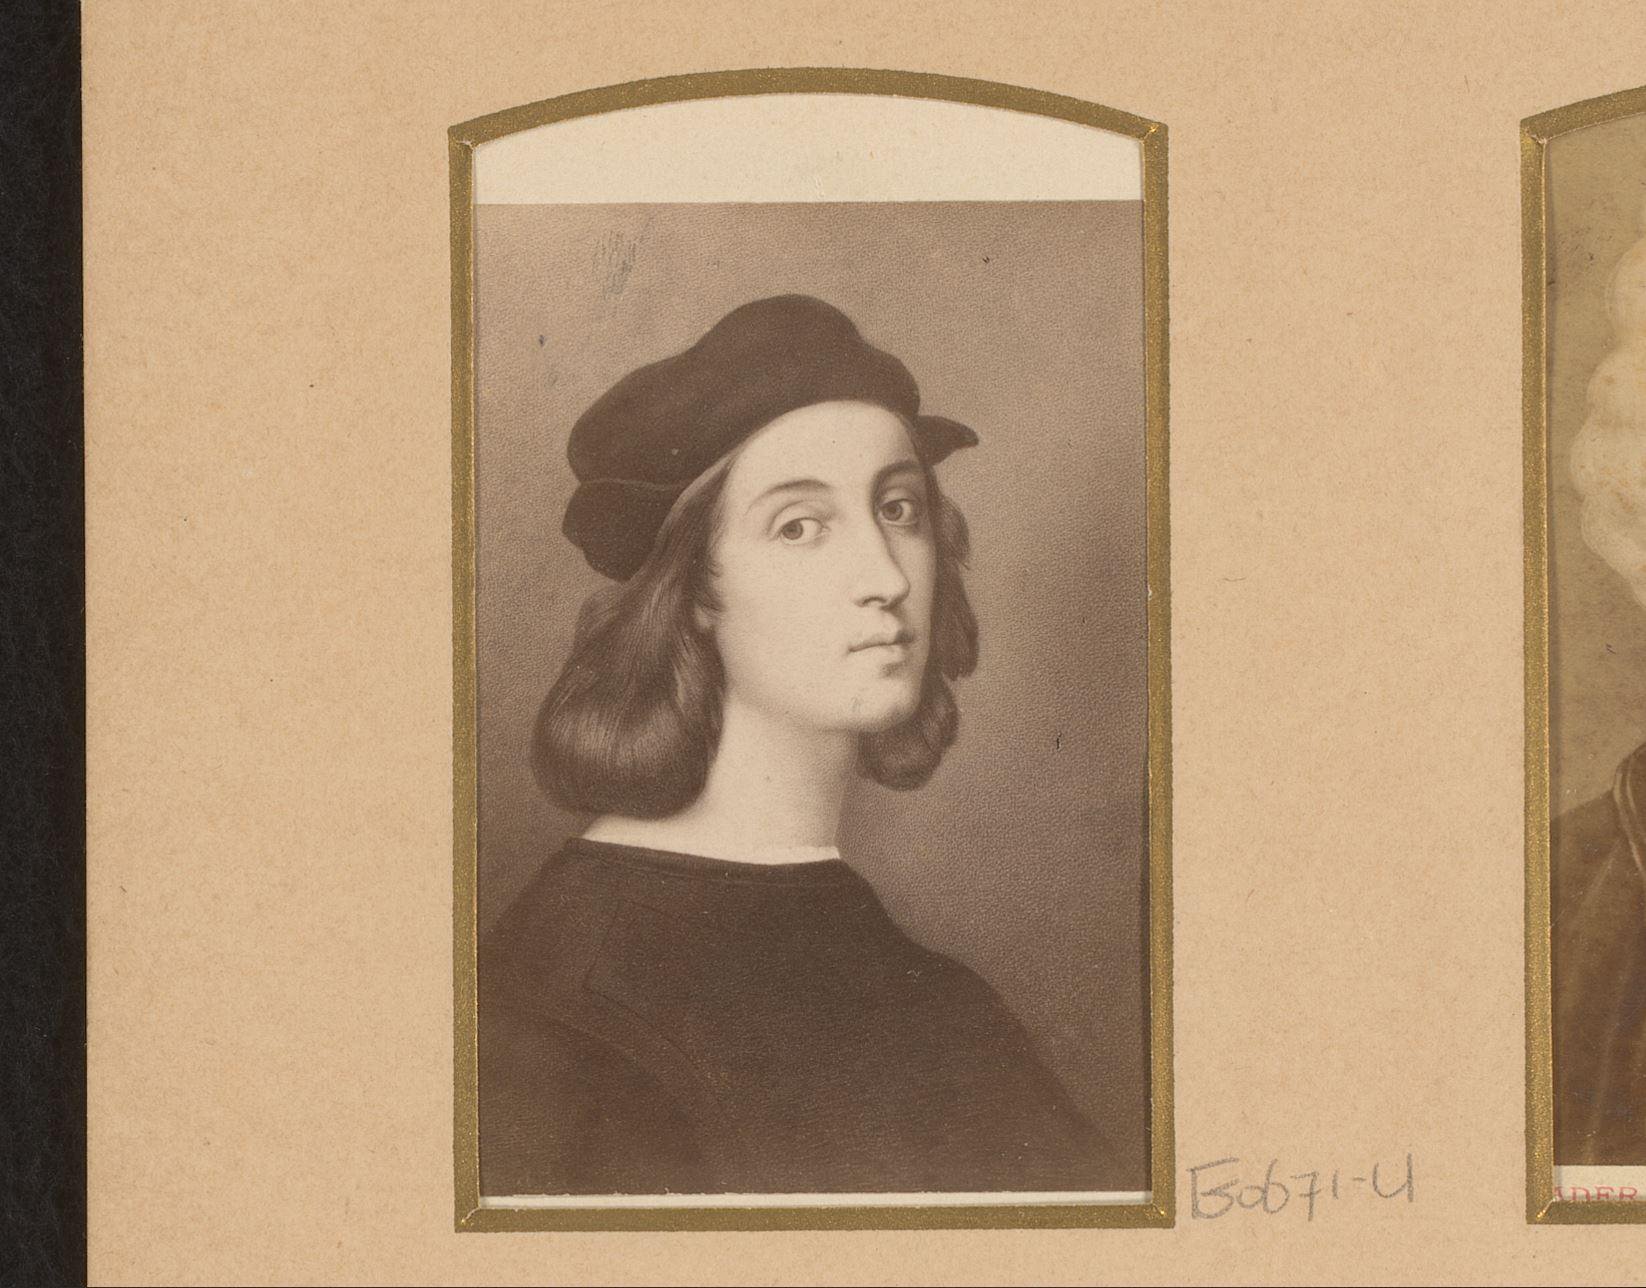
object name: carte de visite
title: Fotoreproductie van een geschilderd zelfportret van Rafaël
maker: Anonymous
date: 1870-1900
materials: cardboard, photographic support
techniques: albumen print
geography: dresden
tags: rome, painter, rafaël, portrait, self-portrait of painter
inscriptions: inscription: ‘Raphael Sanzio./ 47./ Dresden./ Verlag von F. & O. Brockmann.’